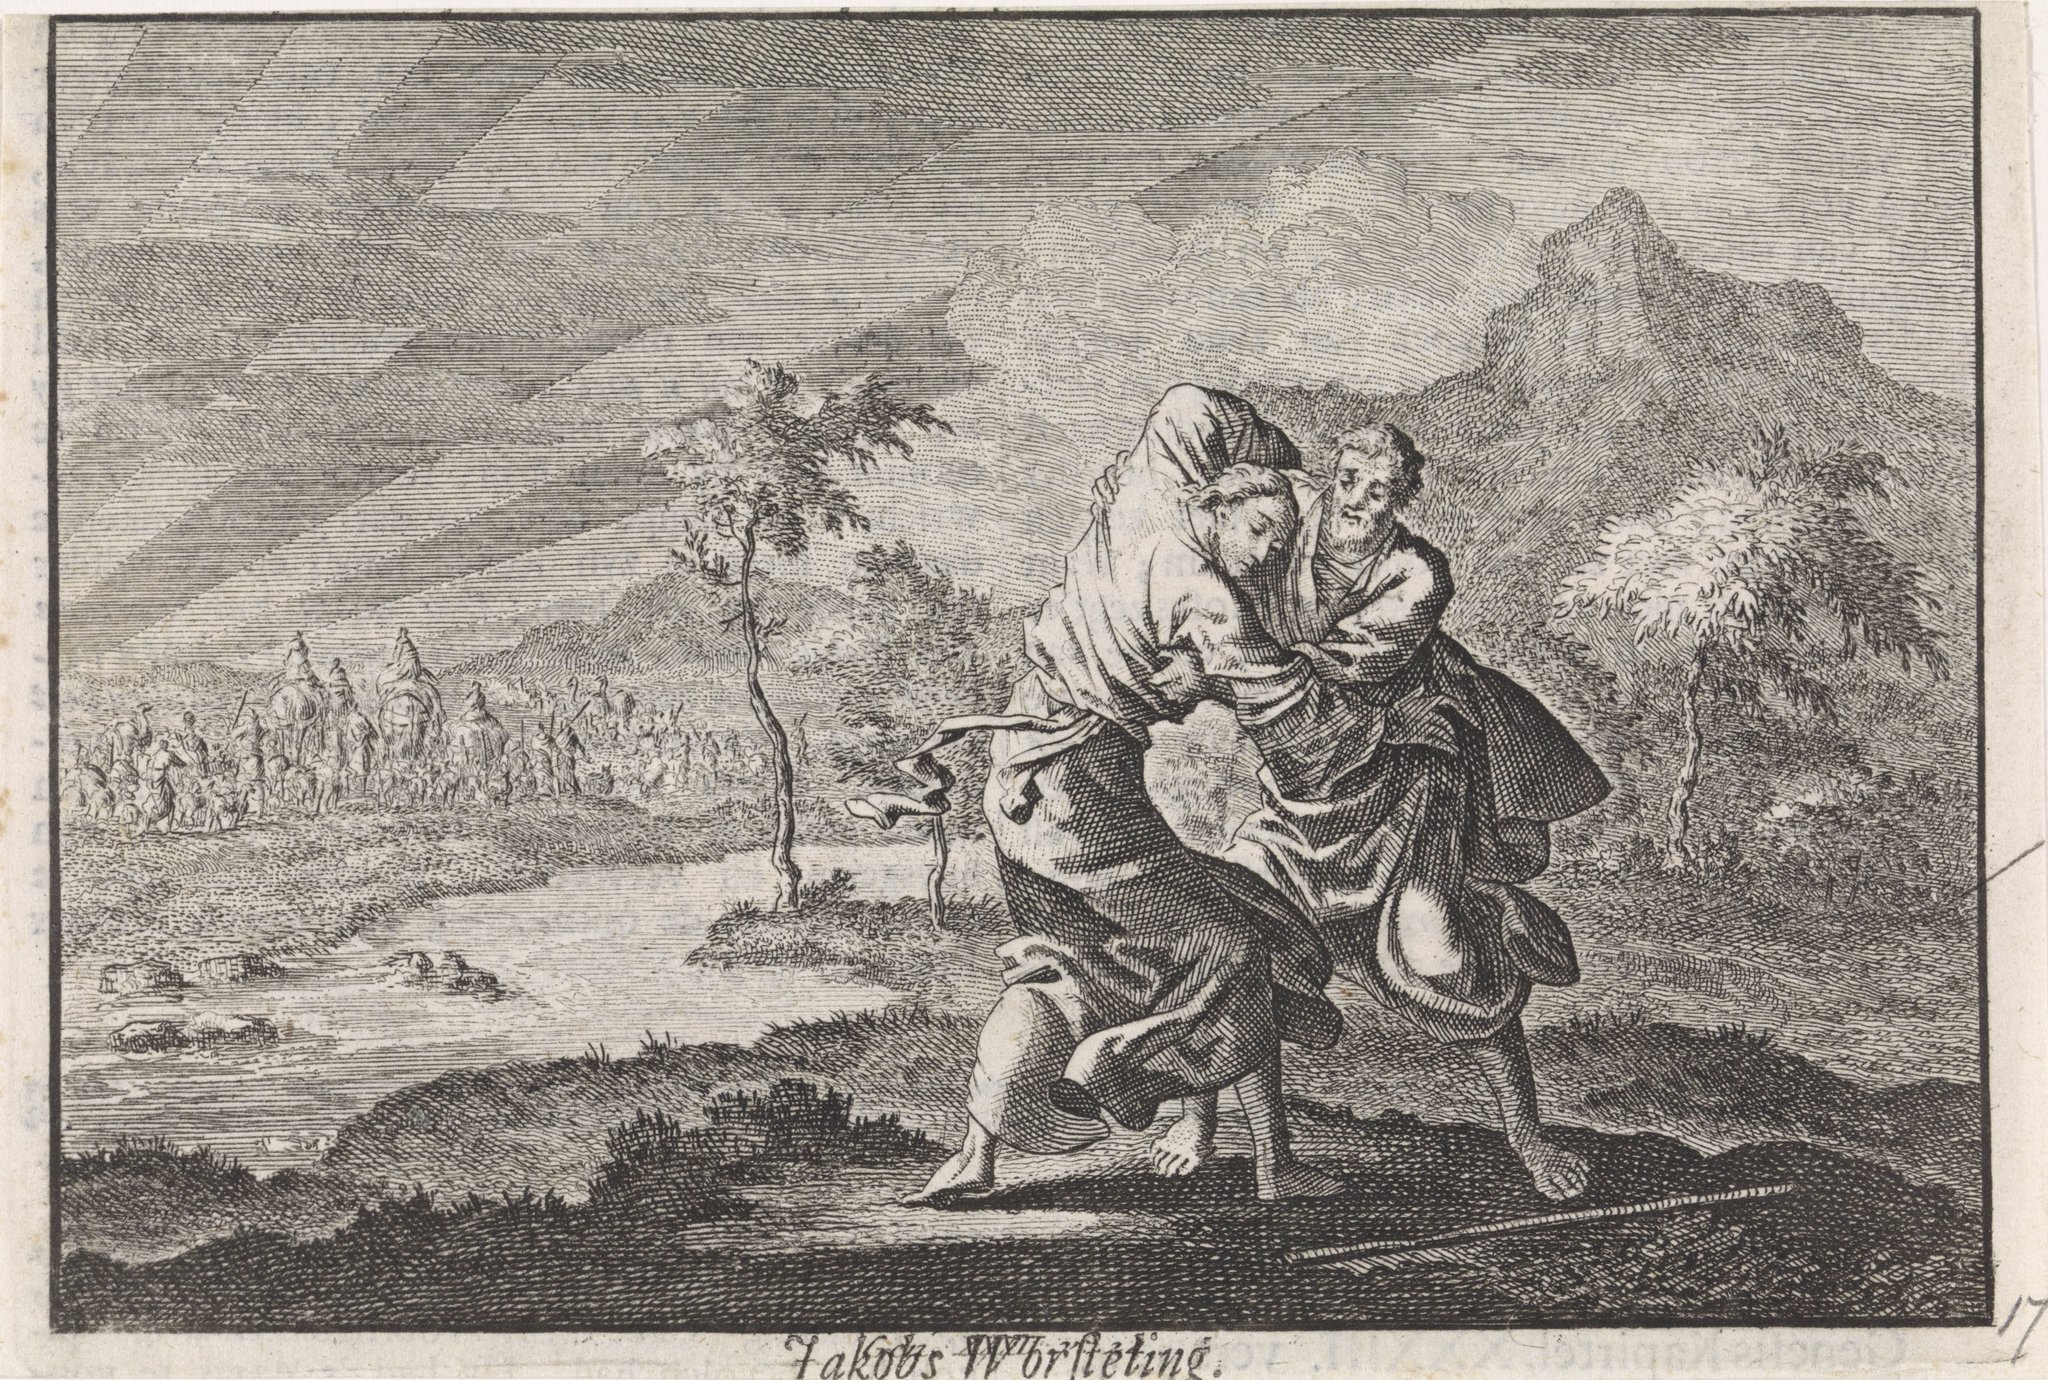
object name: book illustration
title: Jakobs Worsteling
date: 1703-1762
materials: paper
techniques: etching, letterpress printing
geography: amsterdam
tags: jacob wrestles with the angel (or man) till daybreak; jacob's thigh is put out of joint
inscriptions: collector's mark: Lugt 2228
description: De prent komt een eerste keer voor als boekillustratie voor David Martin. Historie des Ouden en Nieuwen Testaments. Amsterdam, Pieter Mortier, 1703. Deel I. De boekillustraties voor de Mortierbijbel hebben verschillende staten en kopieën, waarbij de chronologische volgorde moeilijk te achterhalen valt. Als boekillustraties werden ze bovendien herhaaldelijk opnieuw gebruikt voor andere boekwerken.